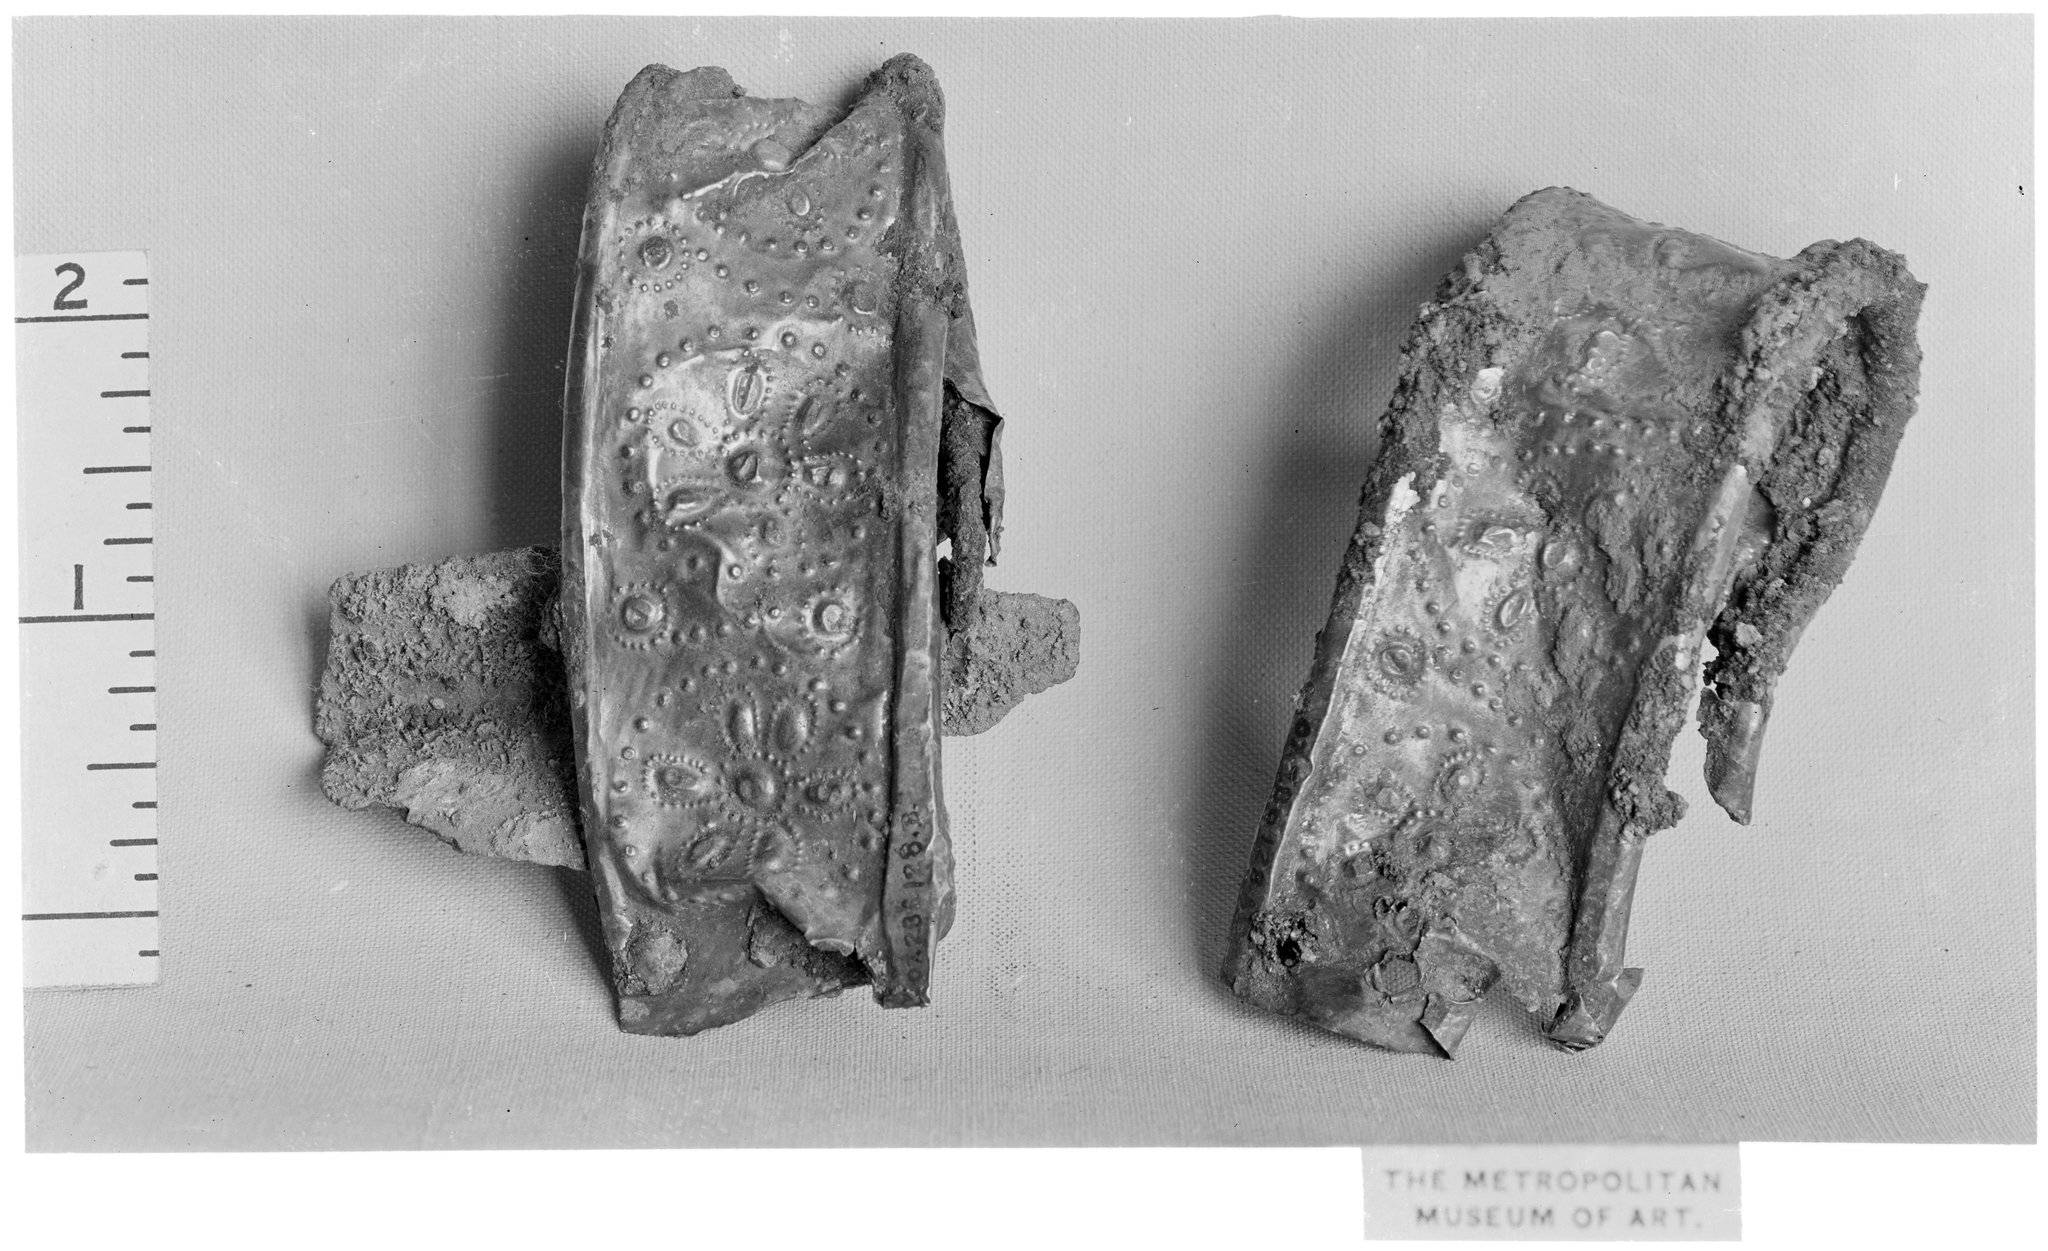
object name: handle of a kantharos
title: Pair of electrum handles from a kantharos (drinking cup with two high vertical handles)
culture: aegean, helladic or mycenaean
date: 1550-1500 BCE